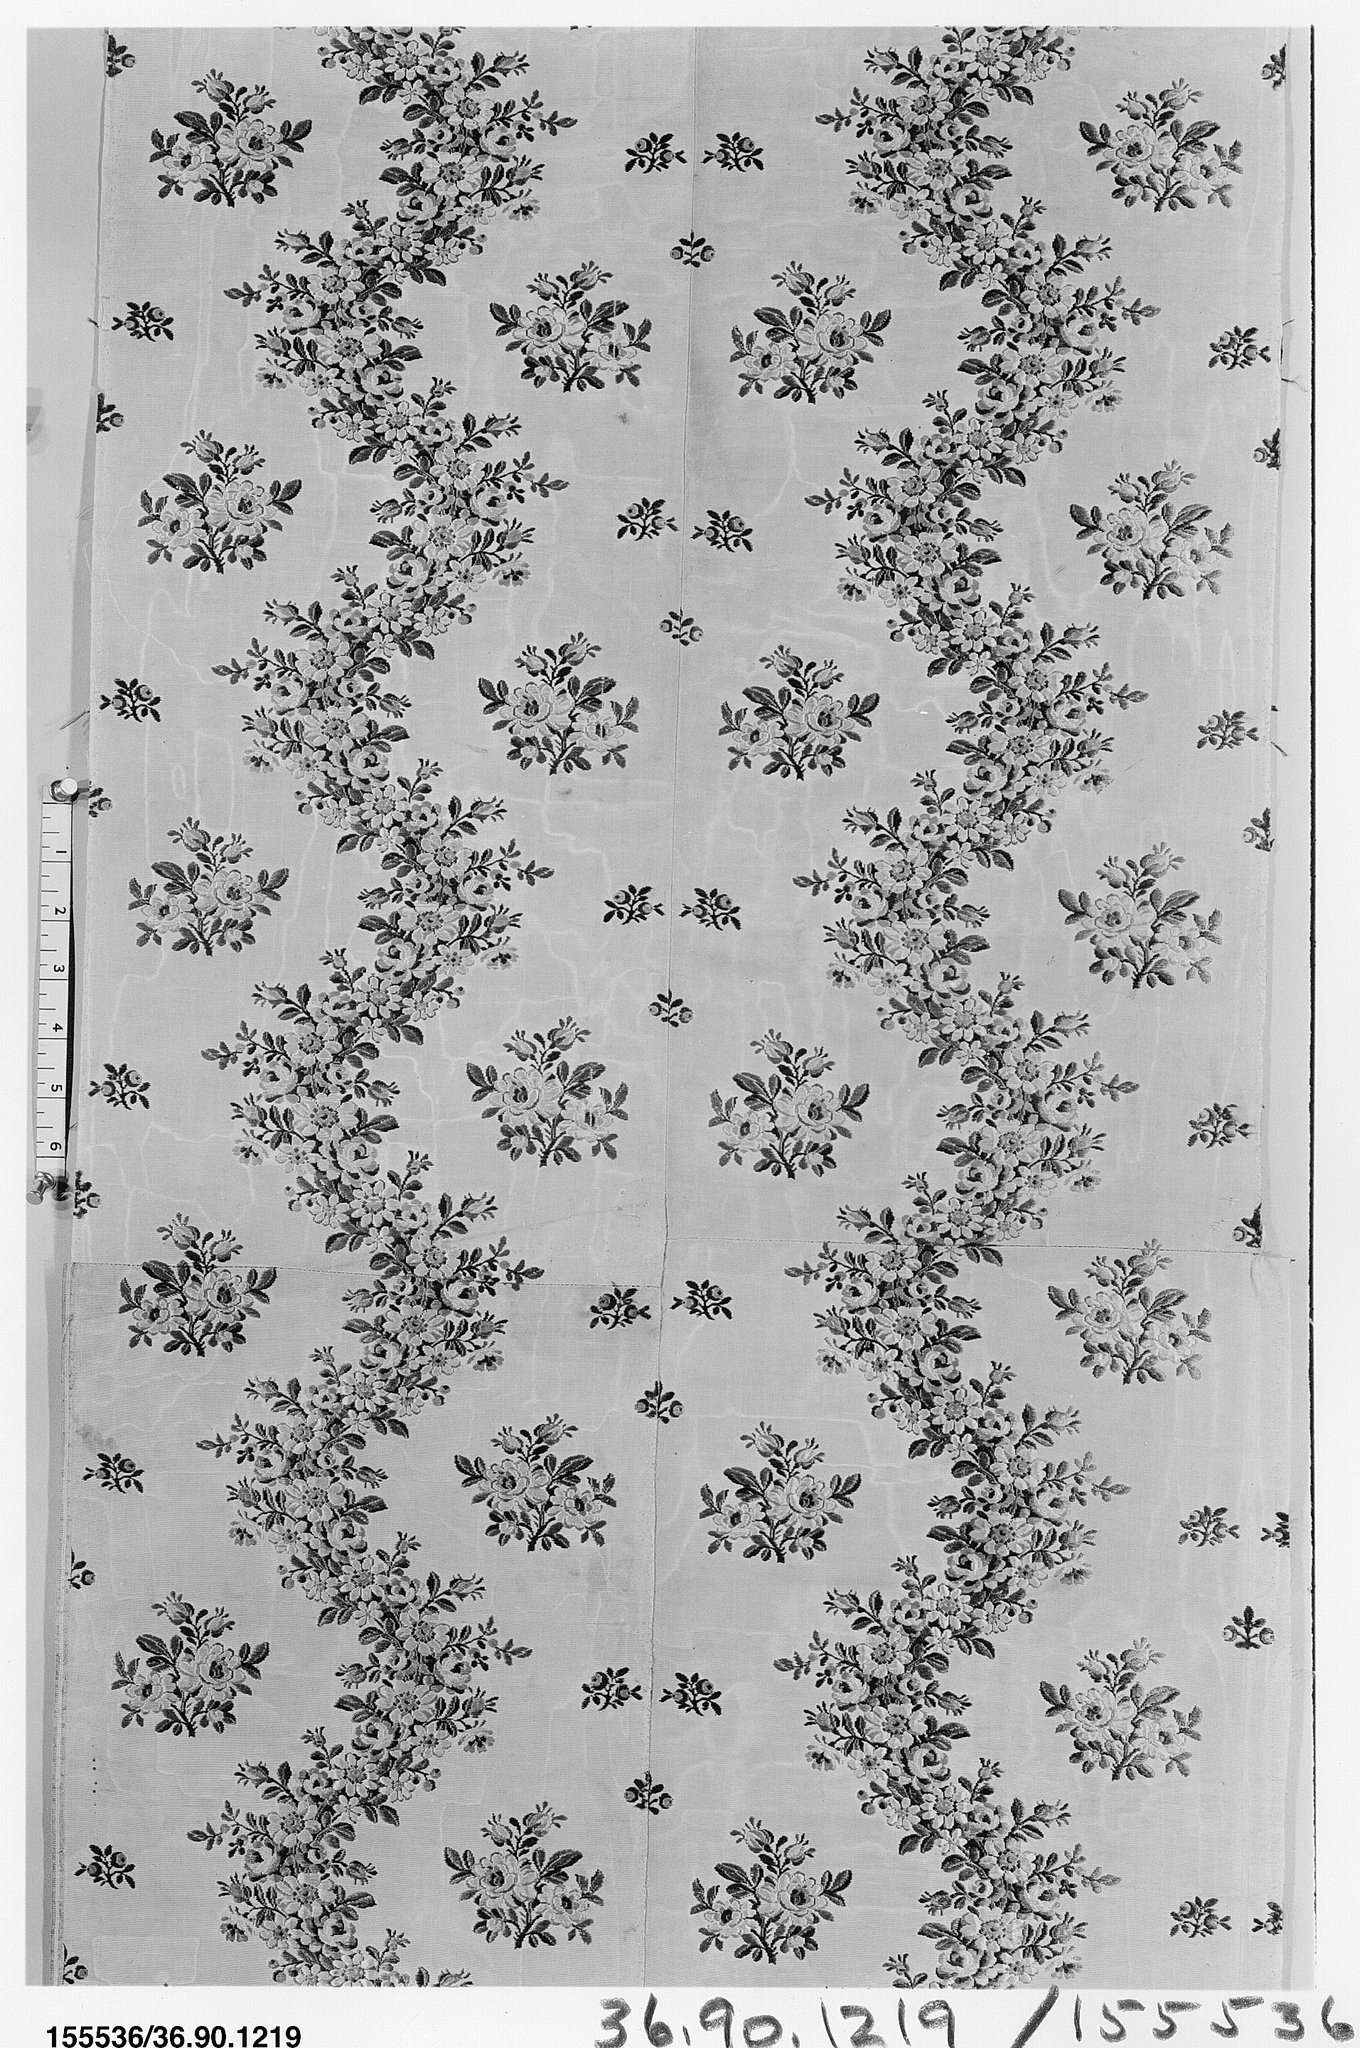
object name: piece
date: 1750-1760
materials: silk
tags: flowers,leaves